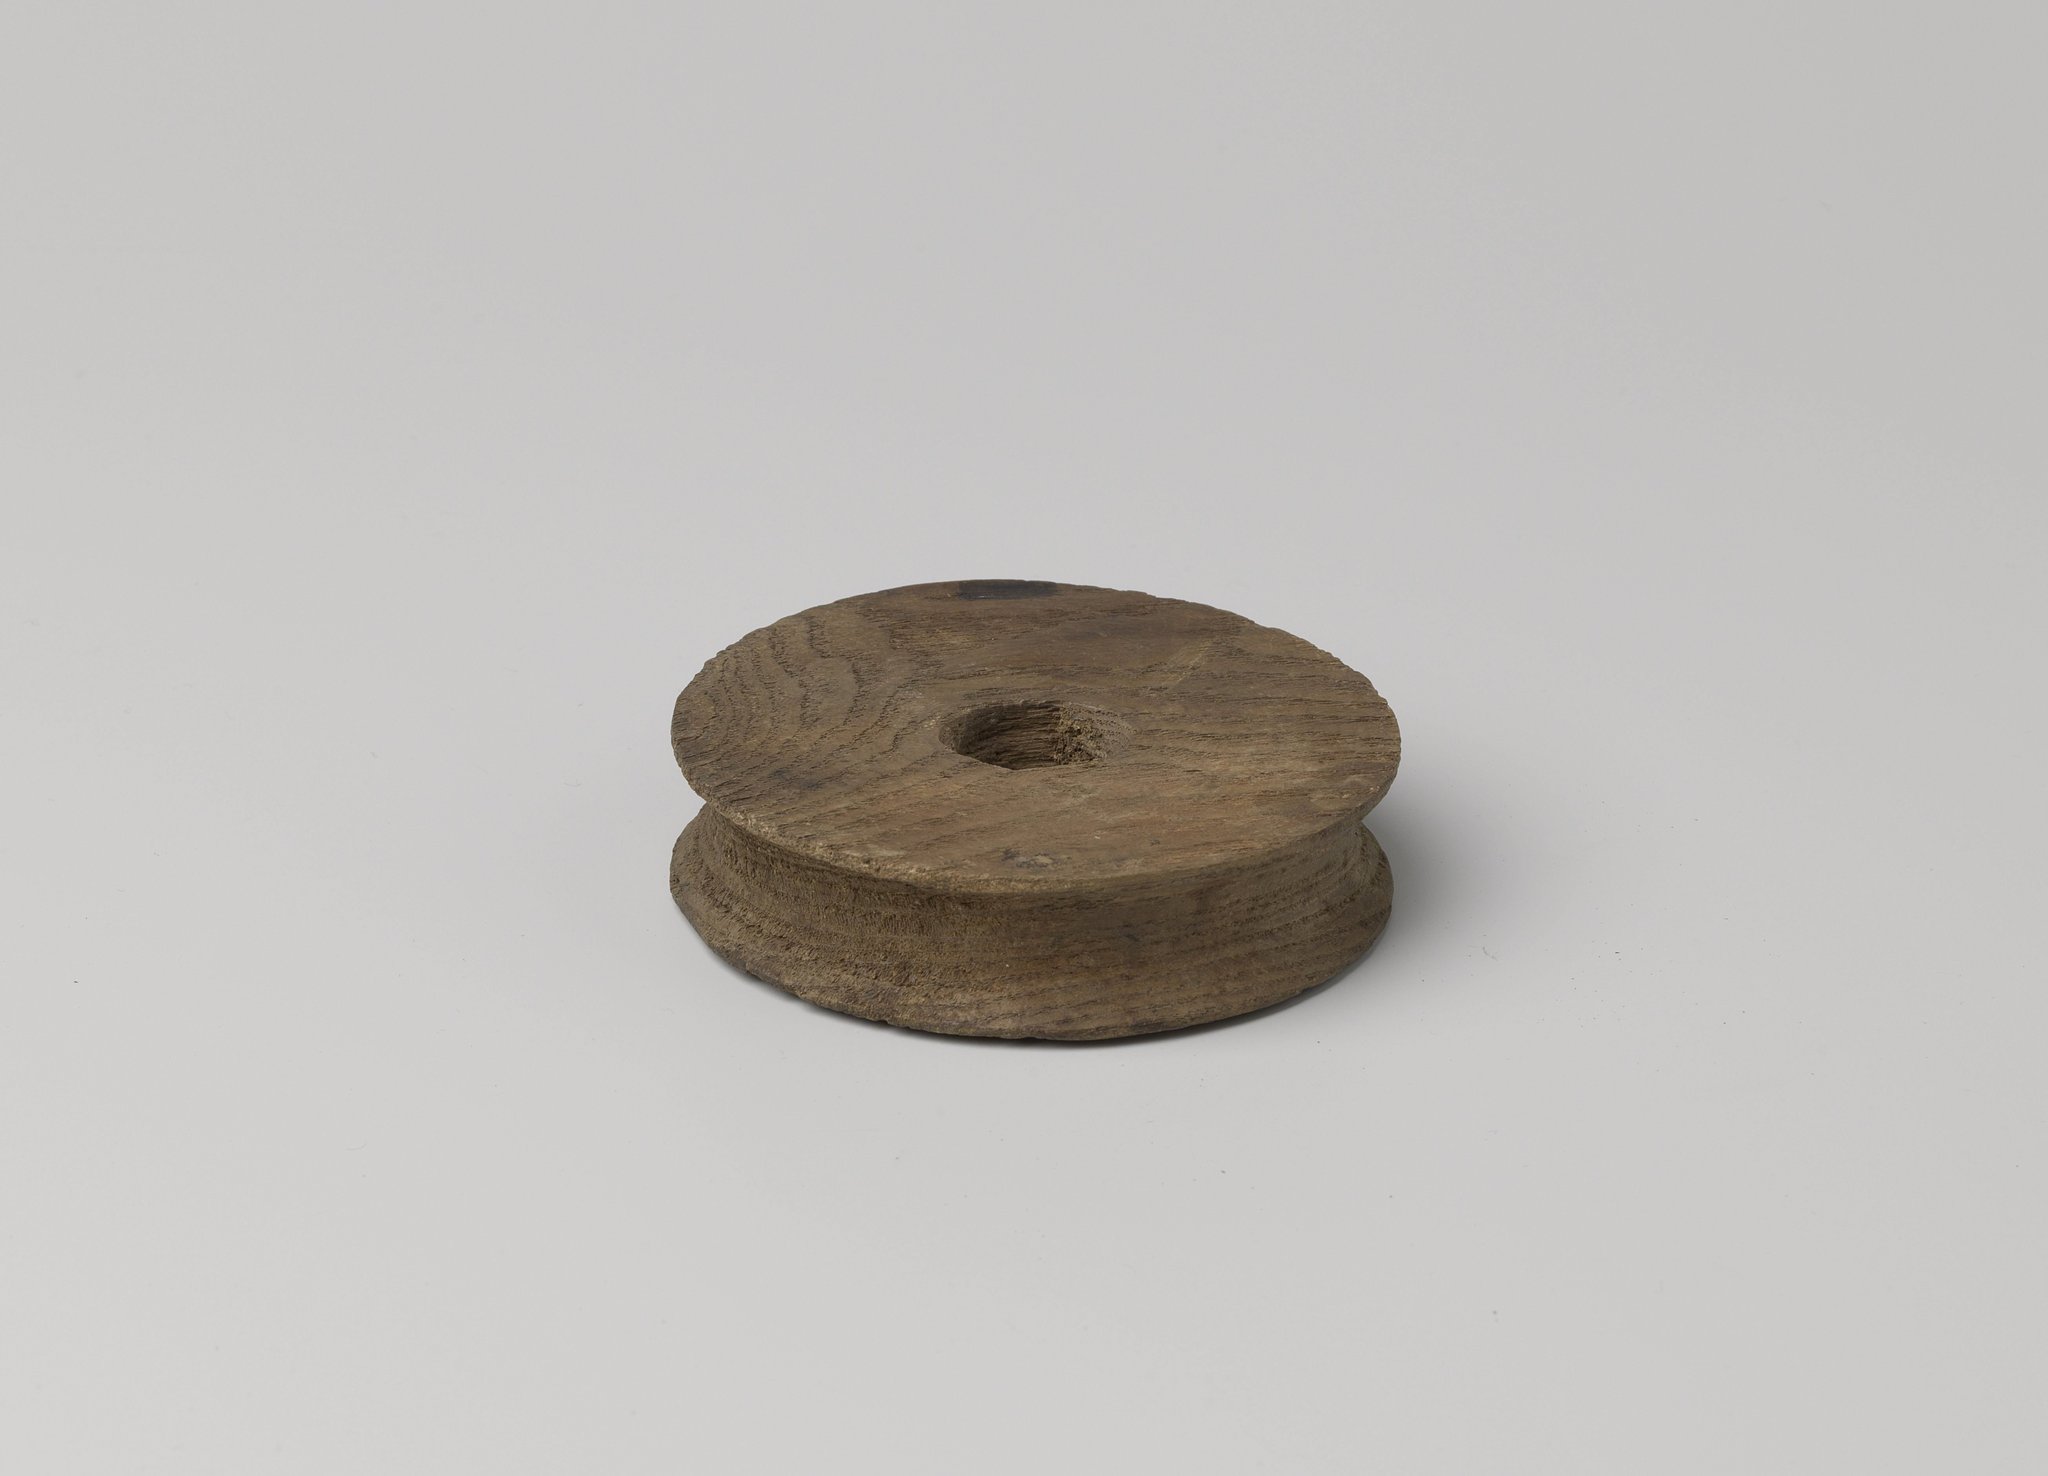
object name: disk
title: Eénschijfsblok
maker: Anonymous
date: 1590-1596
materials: wood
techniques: cutting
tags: willem barendsz., amsterdam, jacob van heemskerck